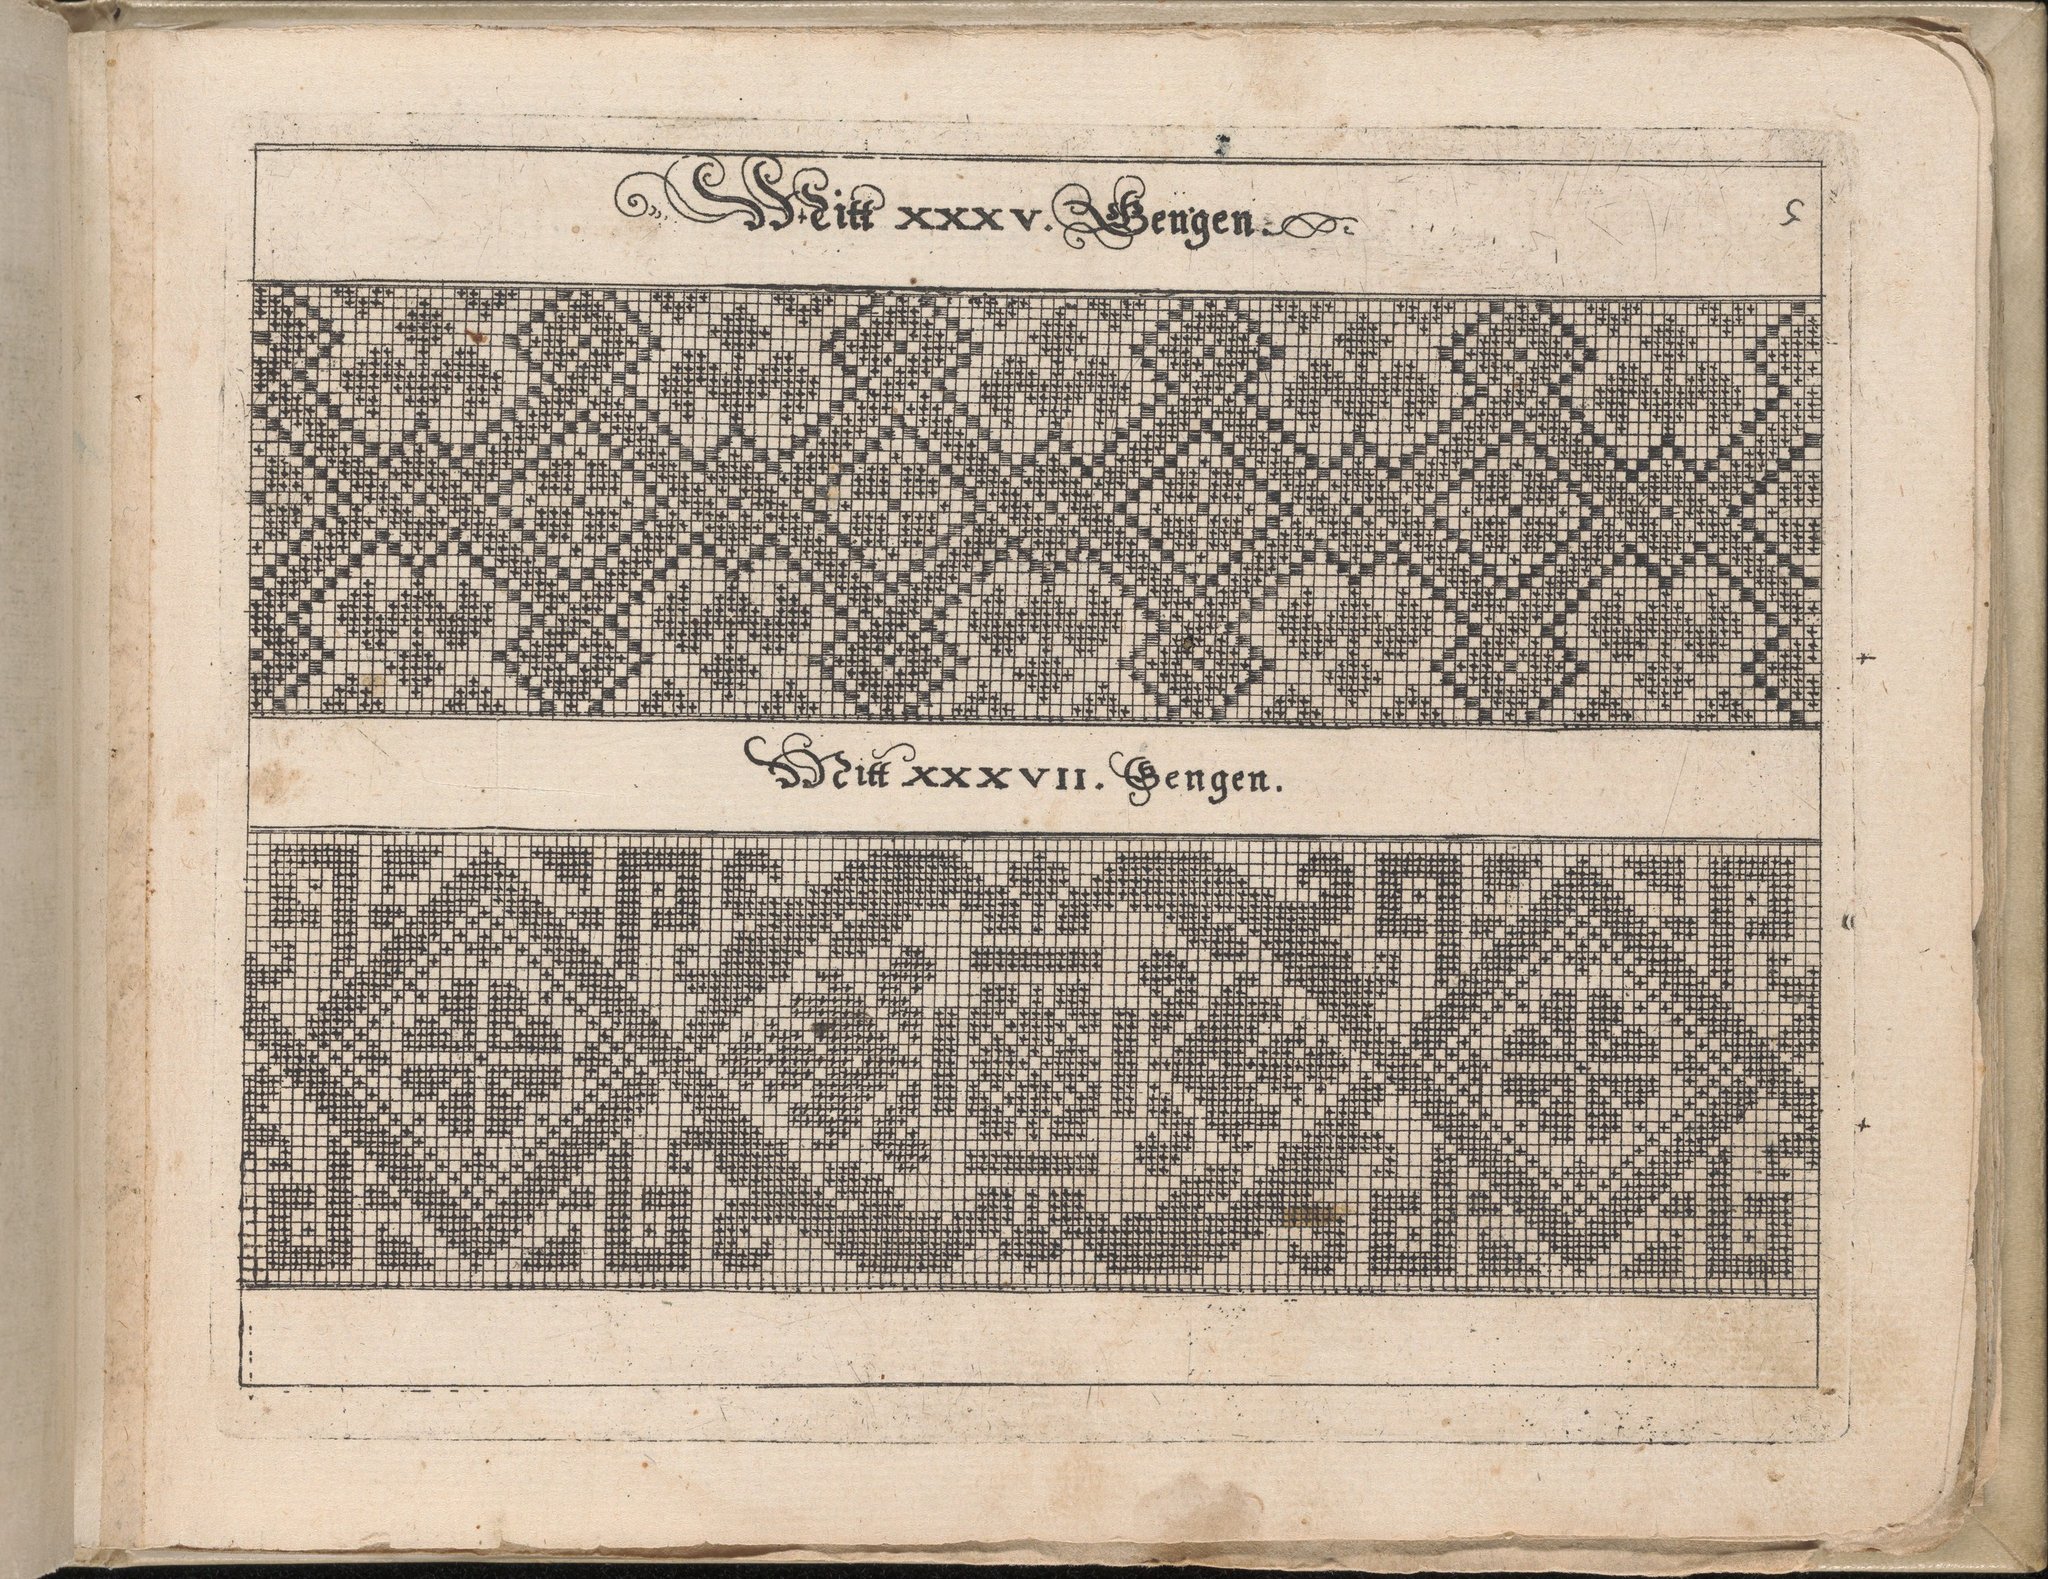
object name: book print ornament architecture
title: Schön Neues Modelbuch (Page 7 recto)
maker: johann sibmacher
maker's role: designer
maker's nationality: german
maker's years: 1590-1611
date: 1597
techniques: etching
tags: ornament